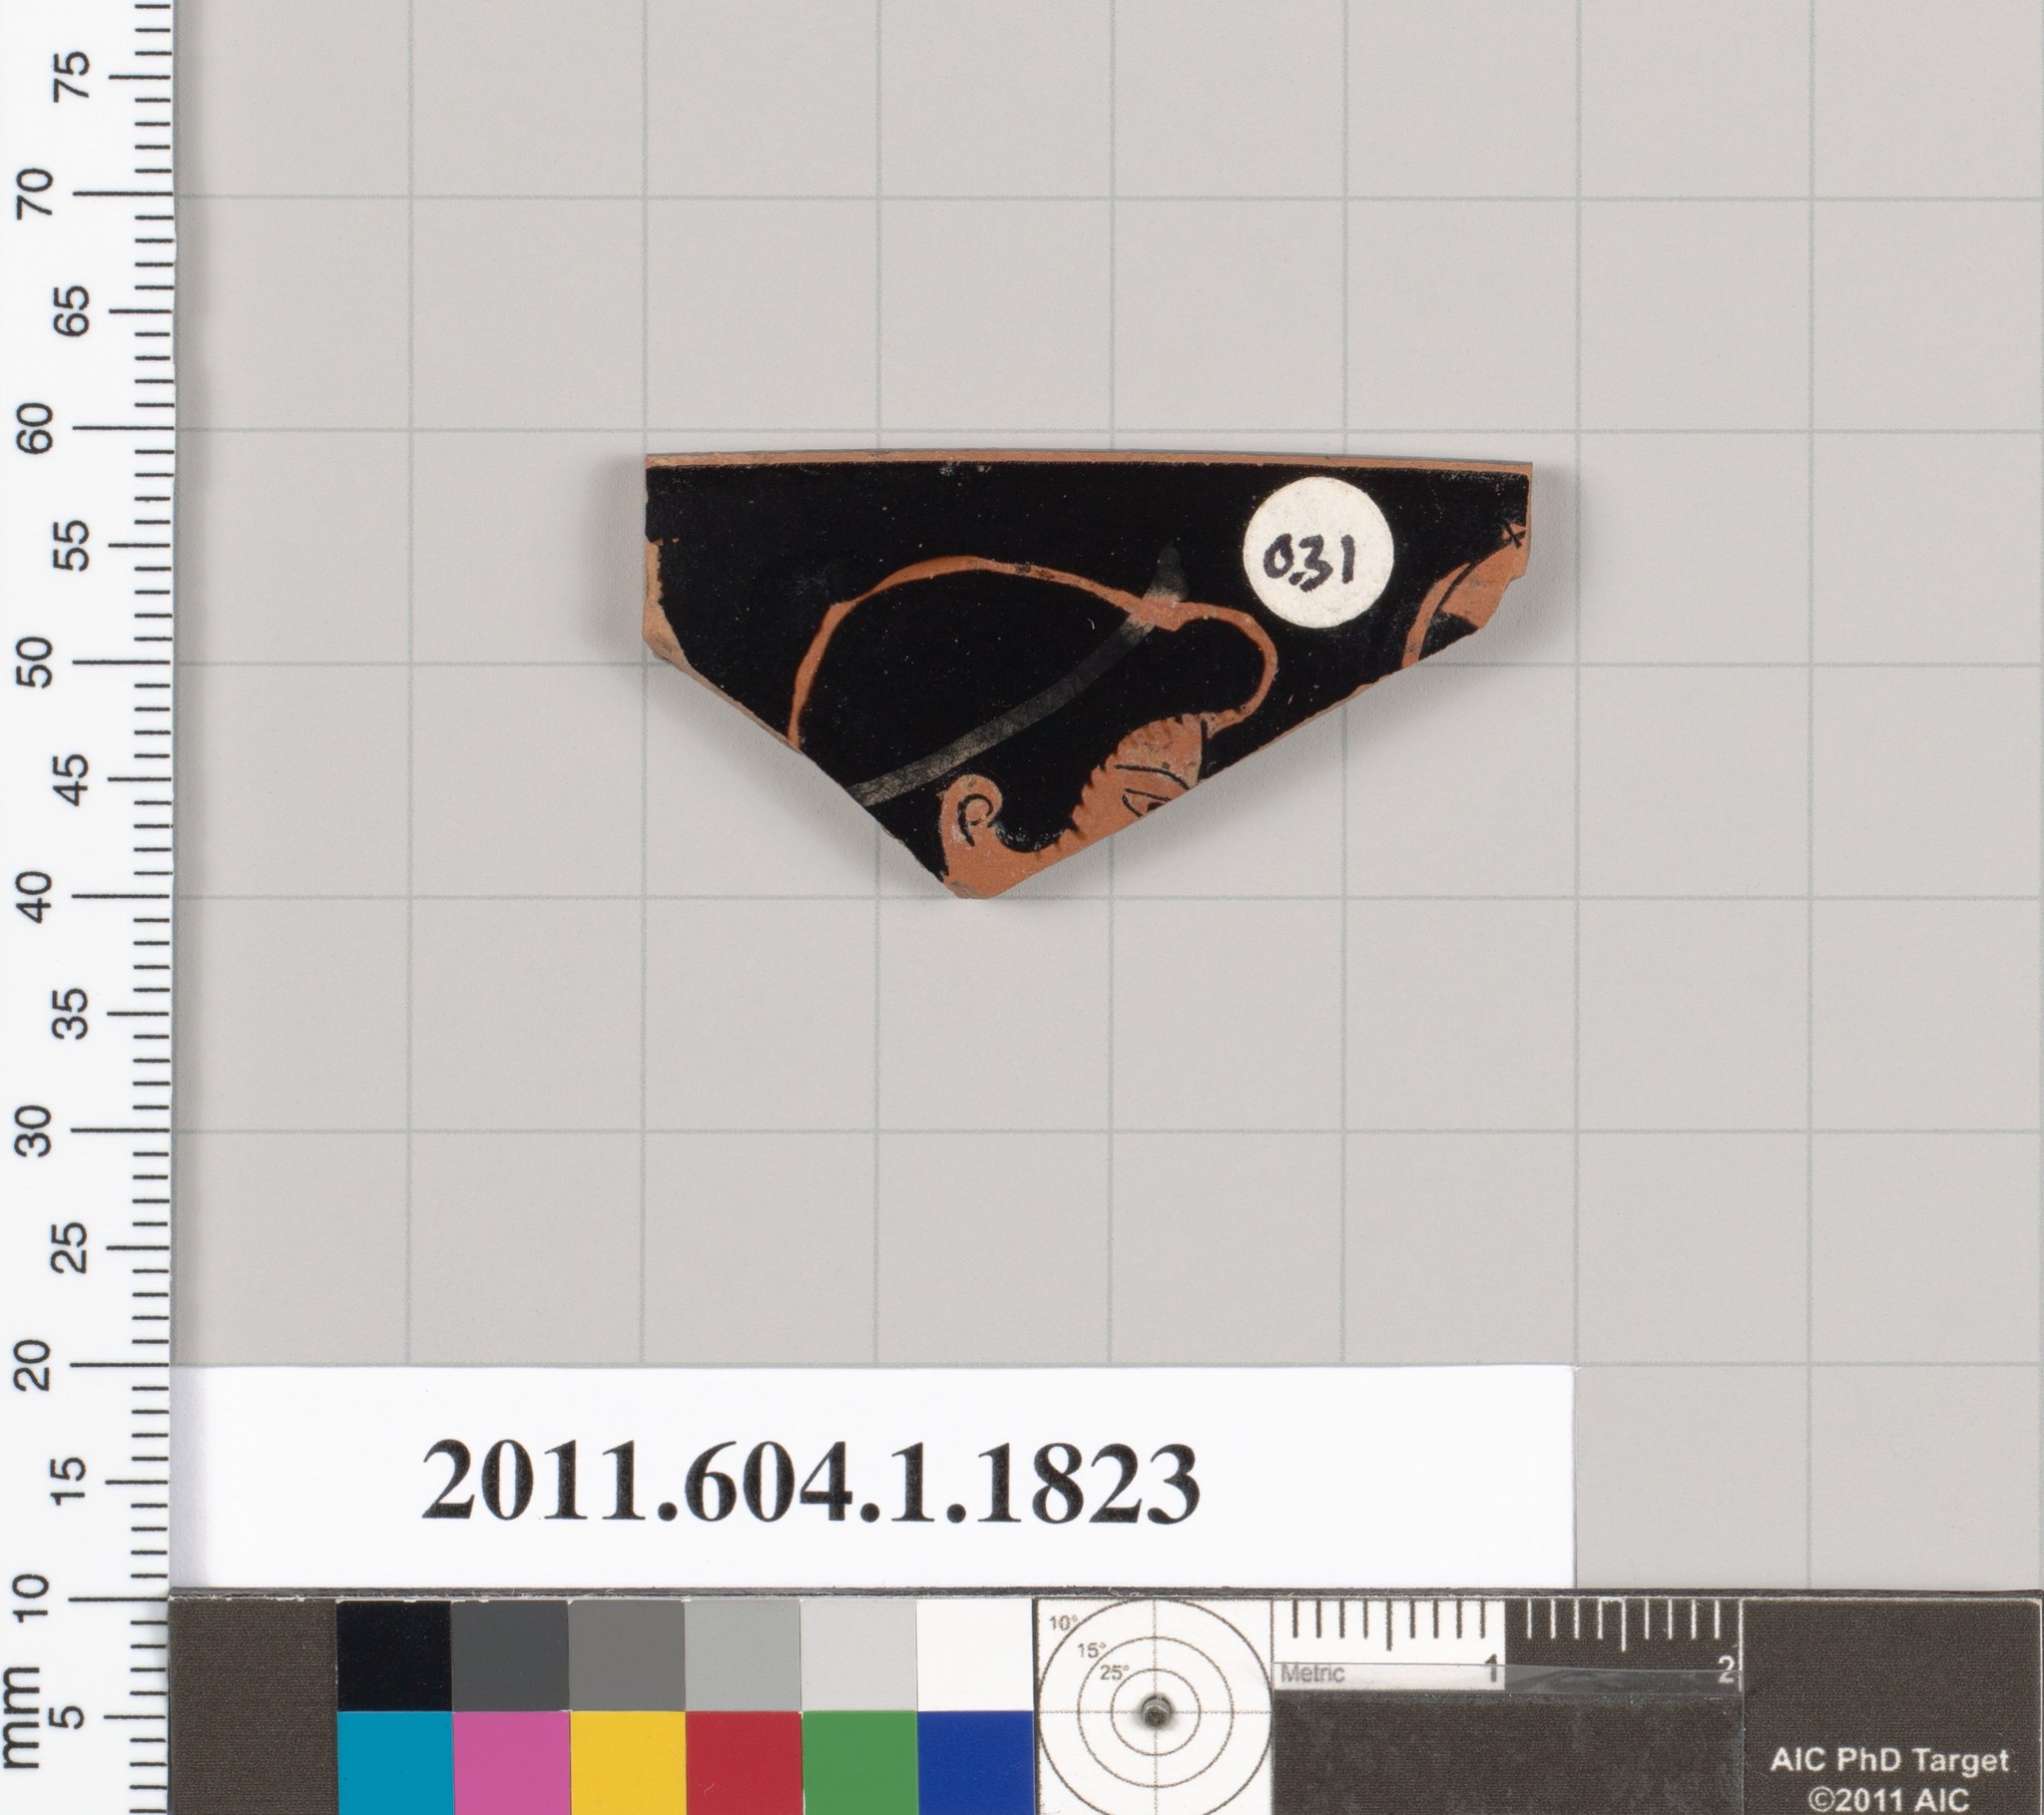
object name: kylix fragment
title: Terracotta rim fragment of a kylix (drinking cup)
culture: greek, attic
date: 510-500 BCE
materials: terracotta